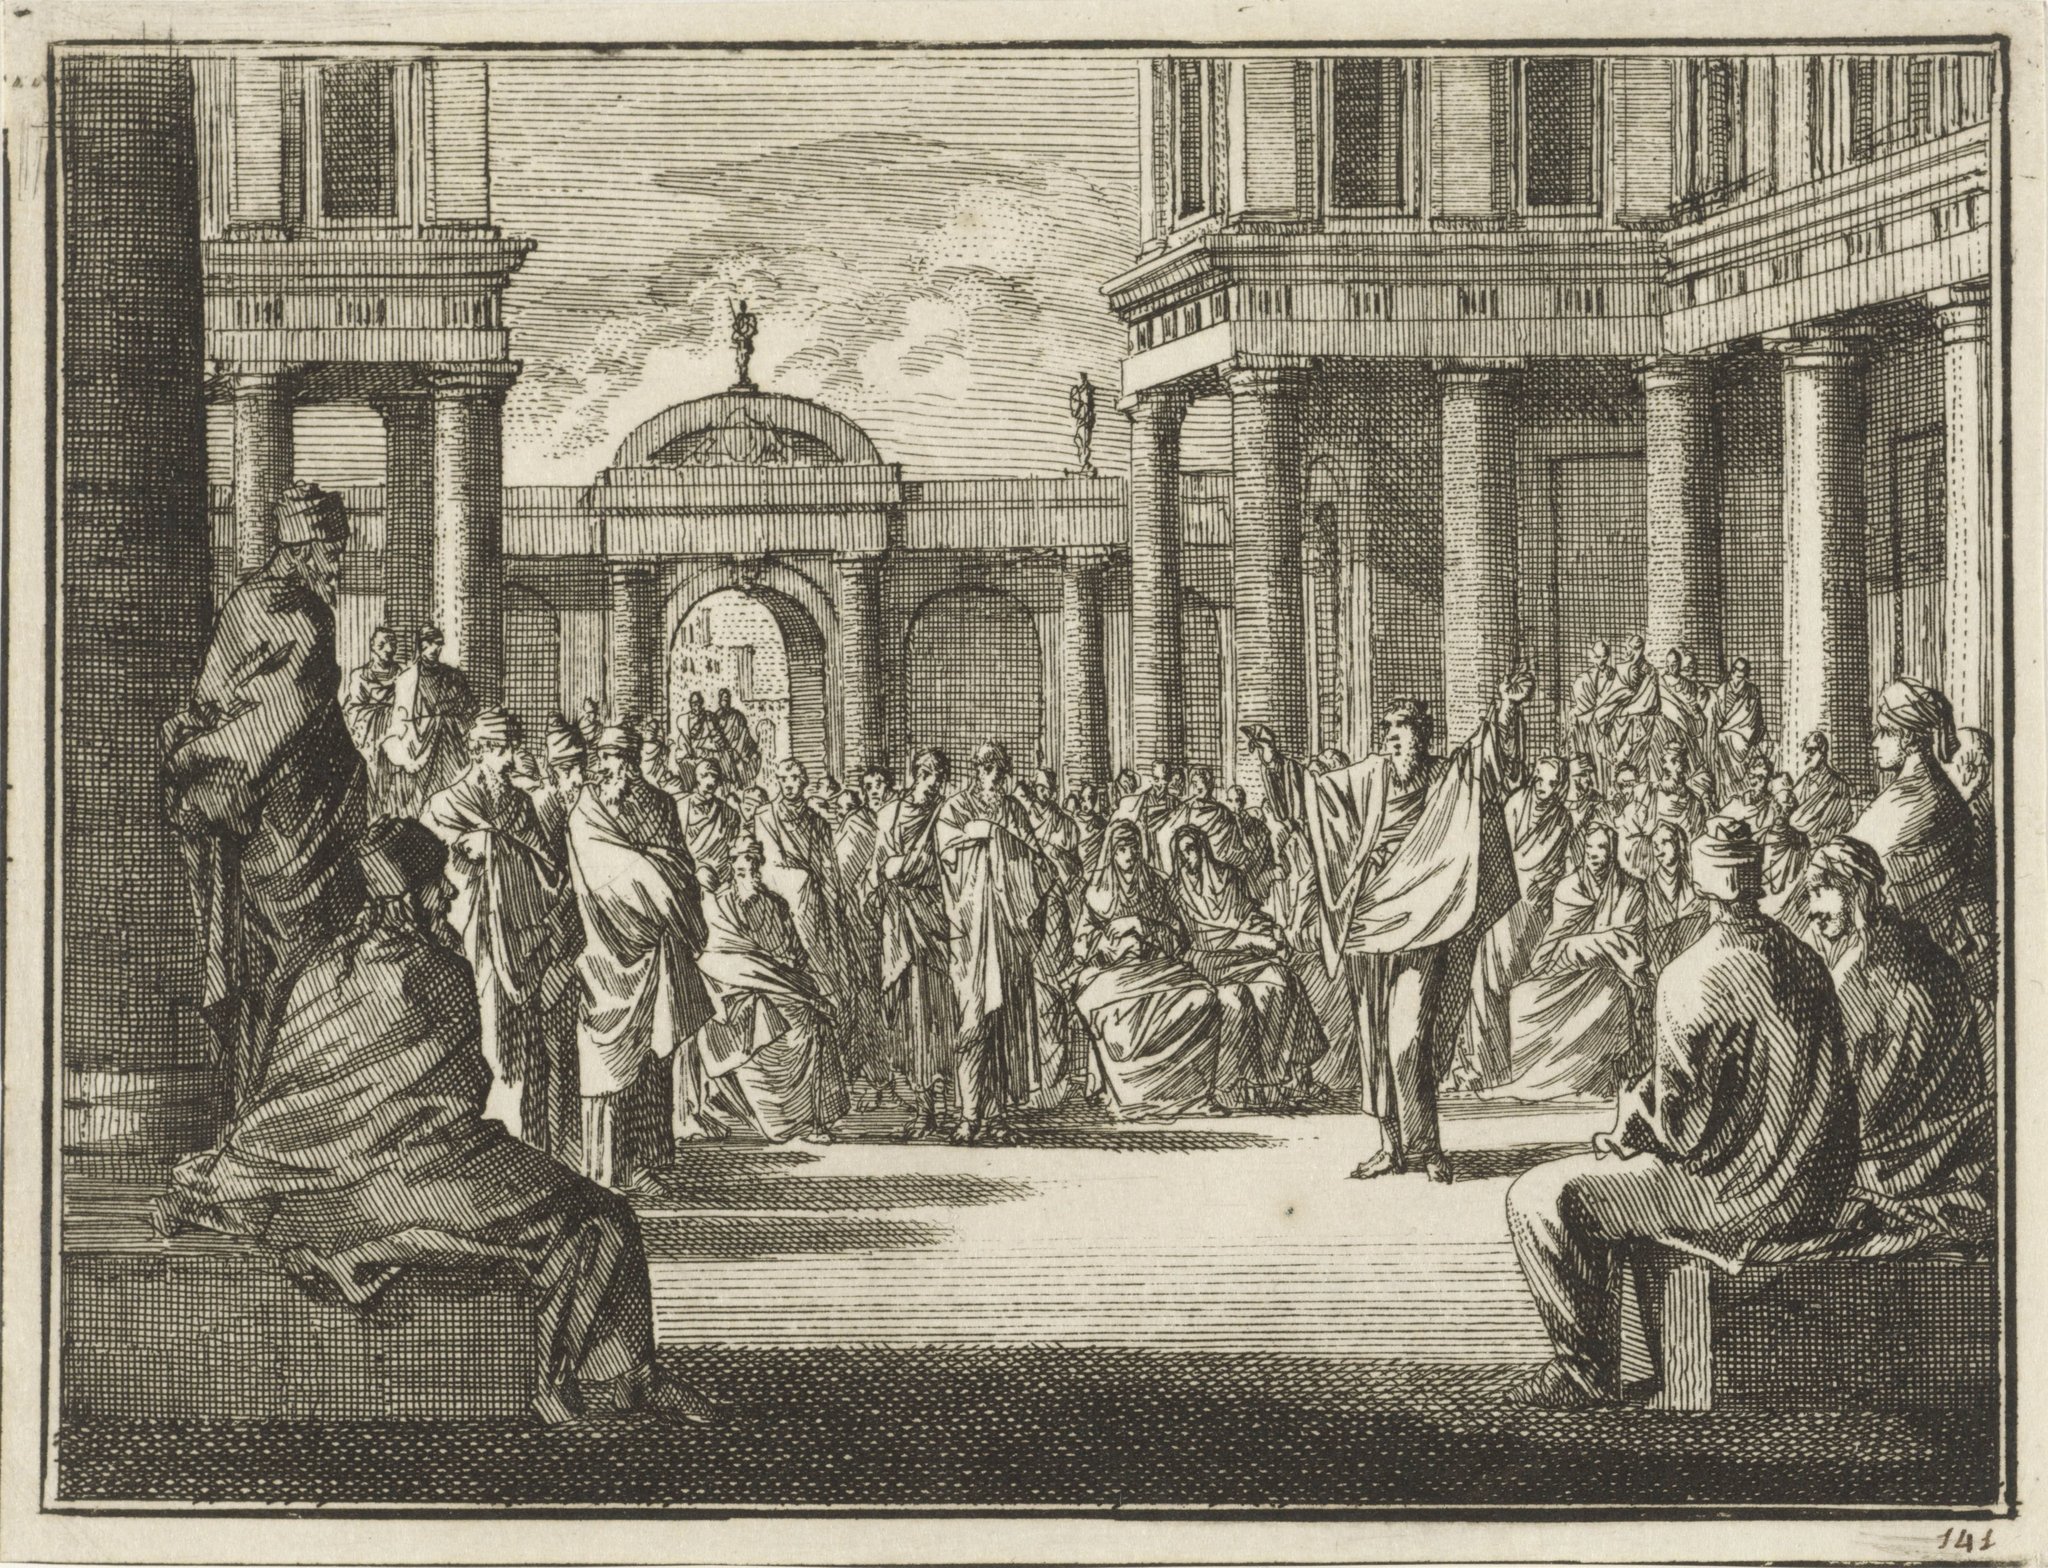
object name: print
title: Paulus voor de leden van de Areopagus in Athene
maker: jan luyken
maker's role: draughtsman, print maker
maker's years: 1649-1712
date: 1712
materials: paper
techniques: etching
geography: amsterdam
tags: paul in athens: on the areopagus he discusses with philosophers (in front of the temple of mars)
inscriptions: collector's mark: Lugt 2228, number: ‘141’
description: Proefdruk van illustratie uit: Luyken, Jan. De schriftuurlyke geschiedenissen en gelykenissen van het Oude en Nieuwe Verbond, 2 delen. Amsterdam: Wed. Pieter Arentsz II en Cornelis van der Sys, 1712, dl. II.